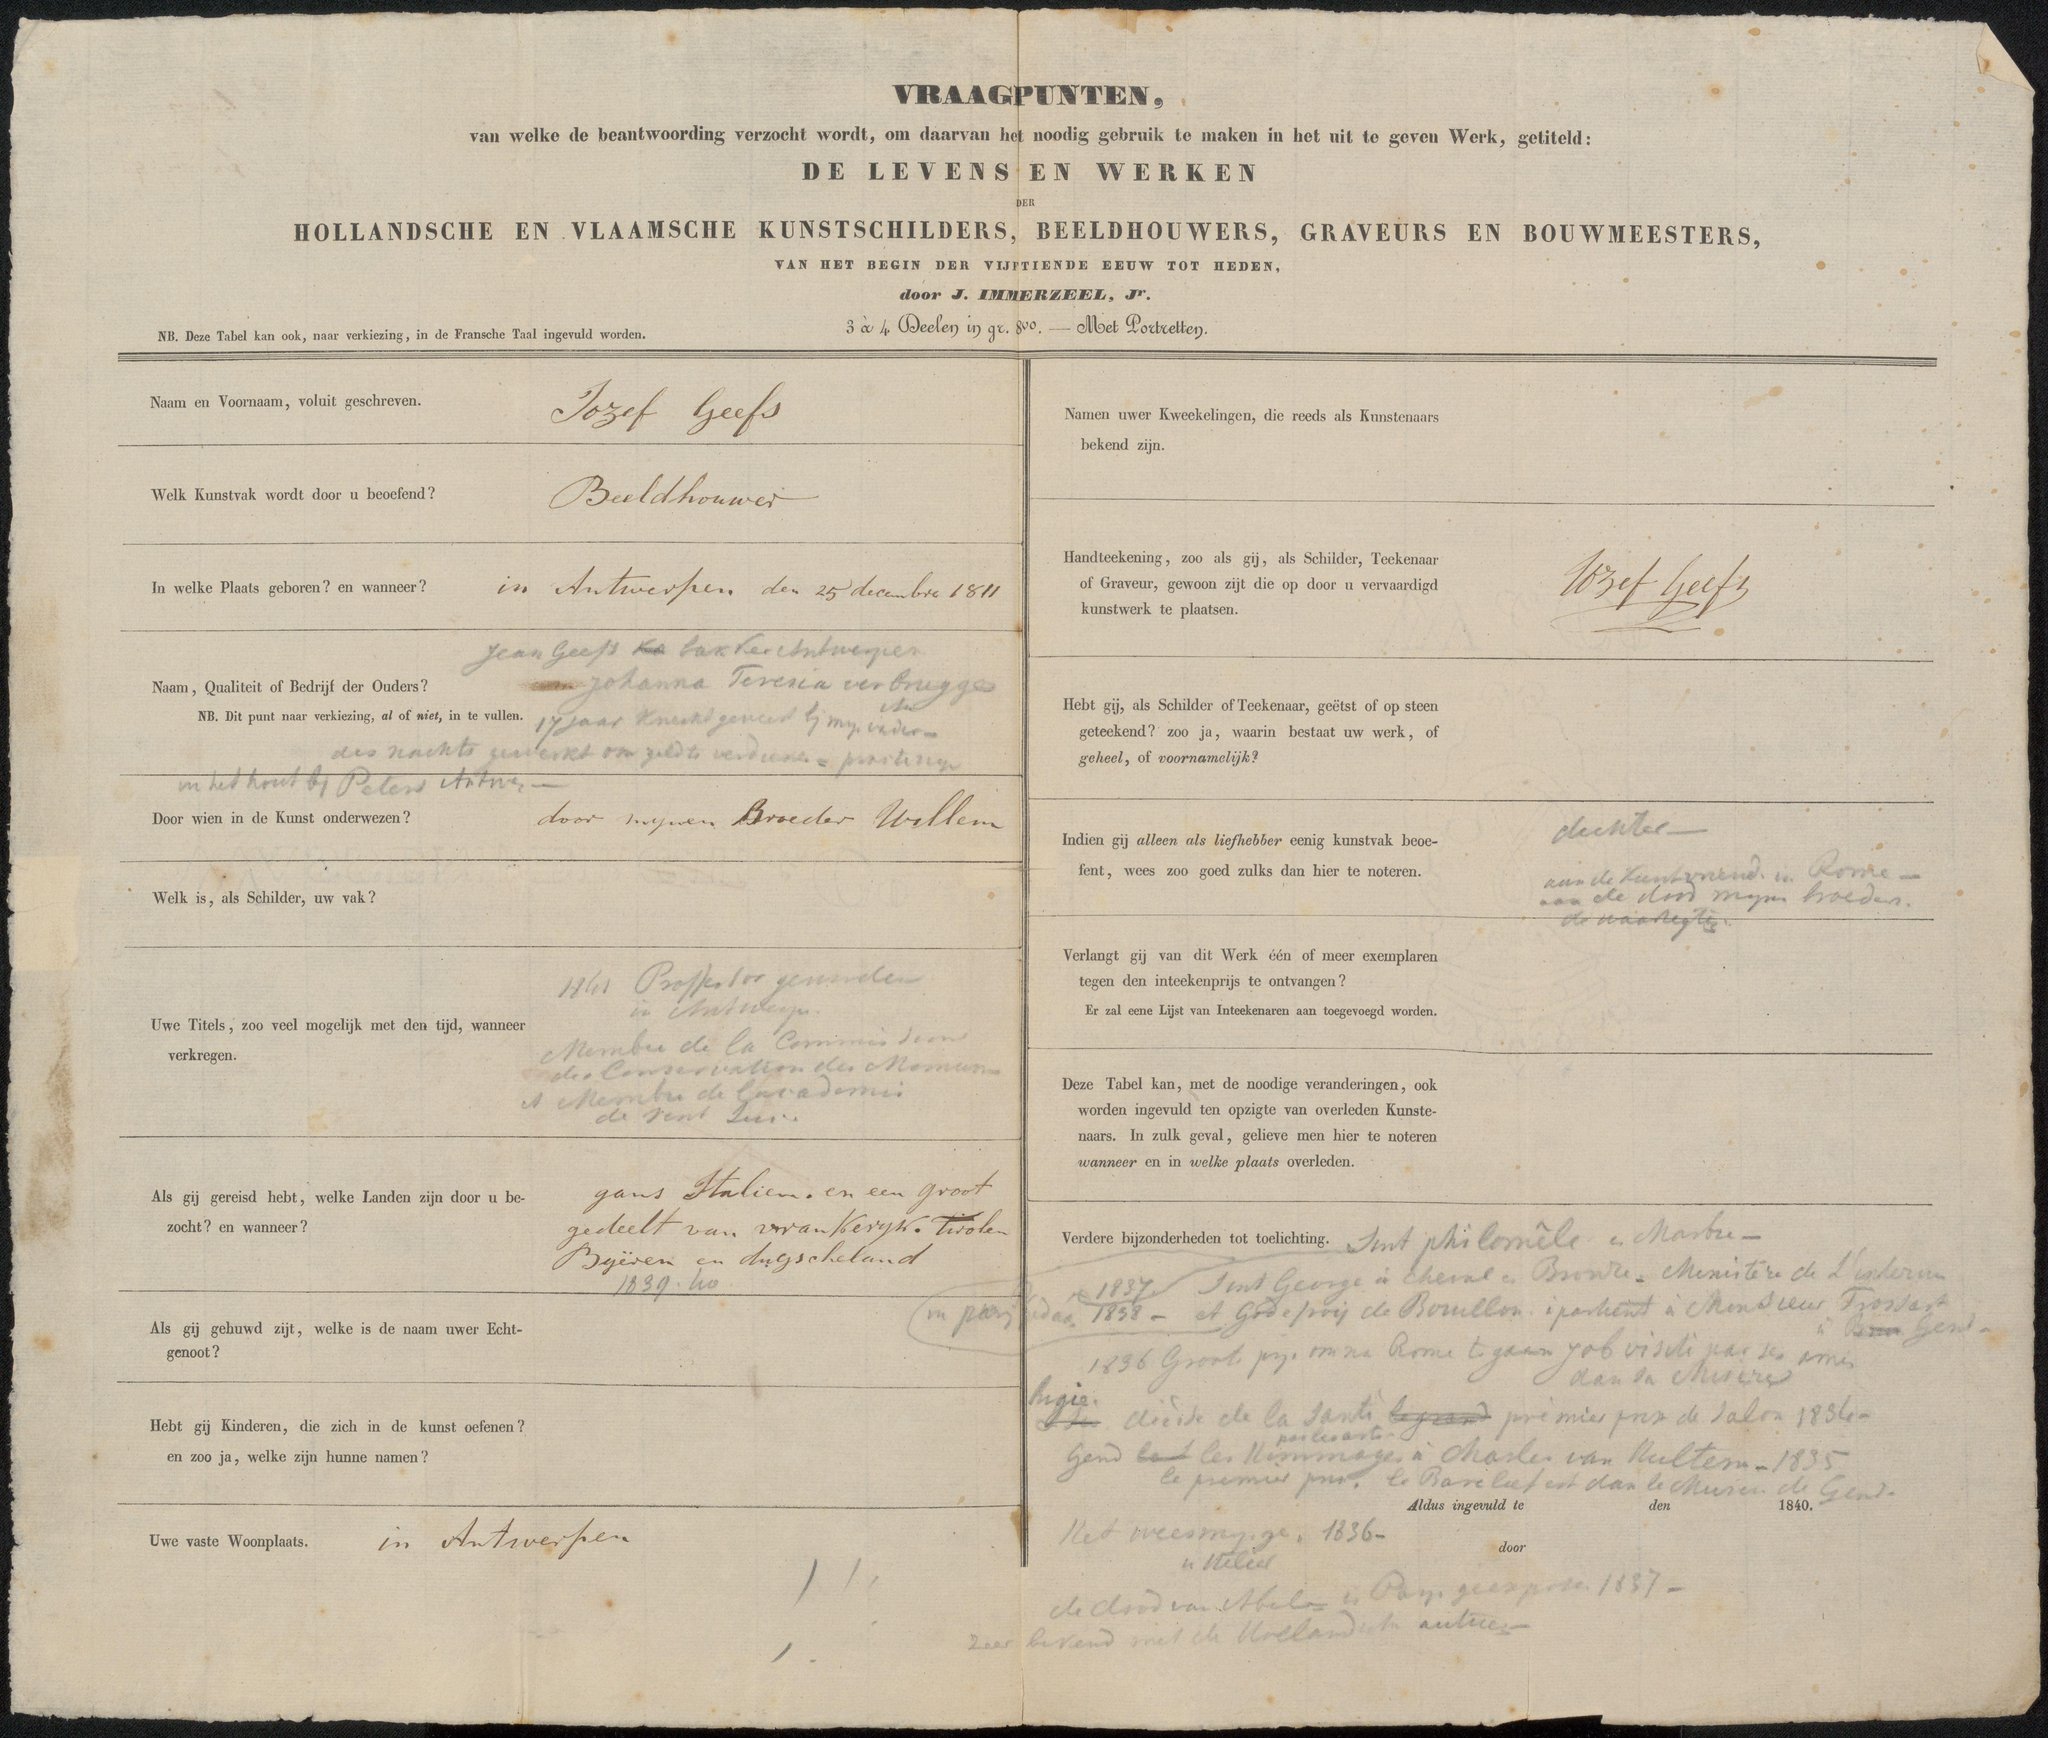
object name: manuscript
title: Enquêteformulier ingevuld door Jozef Geels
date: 1840-1841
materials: ink, paper, pencil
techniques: pen, printing, writing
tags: antwerp, brussels, sculptor, jozef geefs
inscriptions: watermark, inscription: ‘Vraagpunten,/ van welke de beantwoording verzocht wordt, om daarvan het noodig gebruik te maken in het uit te geven Werk, getiteld: De levens en werken/ der Hollandsche en Vlaamsche kunstschilders, beeldhouwers,/ graveurs en bouwmeesters, van het begin der vijftiende eeuw tot heden/ door J. Immerzeel, Jr.’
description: Opgenomen in: Immerzeel, J. Jr., De levens en werken der Hollandsche en Vlaamsche kunstschilders, beeldhouwers, graveurs en bouwmeesters, van het begin der vijftiende eeuw tot heden, Amsterdam: J.C. van Kesteren, 1842-1843.